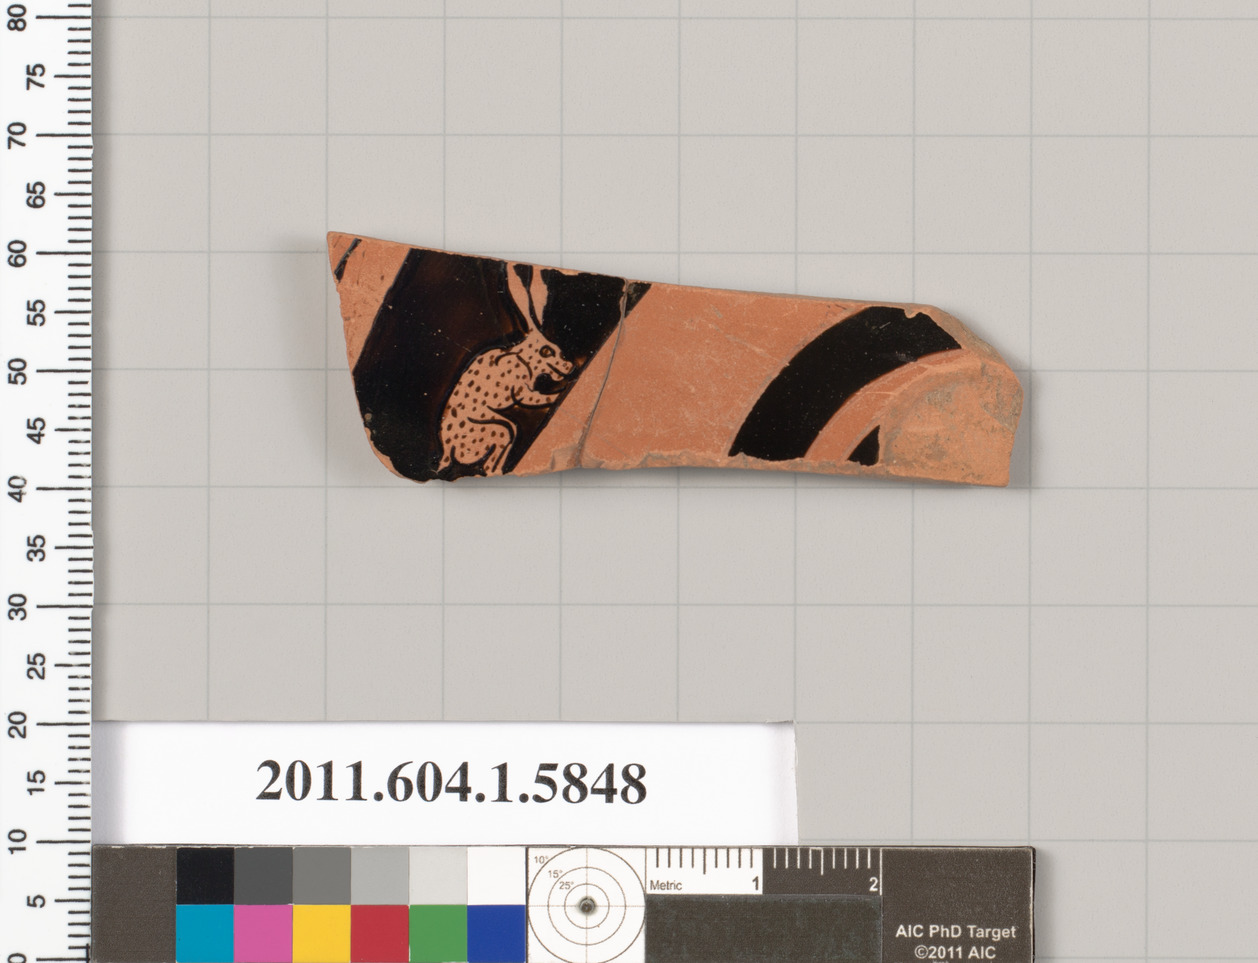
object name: kylix fragment, eye cup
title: Terracotta fragment of a kylix: eye-cup (drinking cup)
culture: greek, attic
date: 534-468 BCE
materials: terracotta